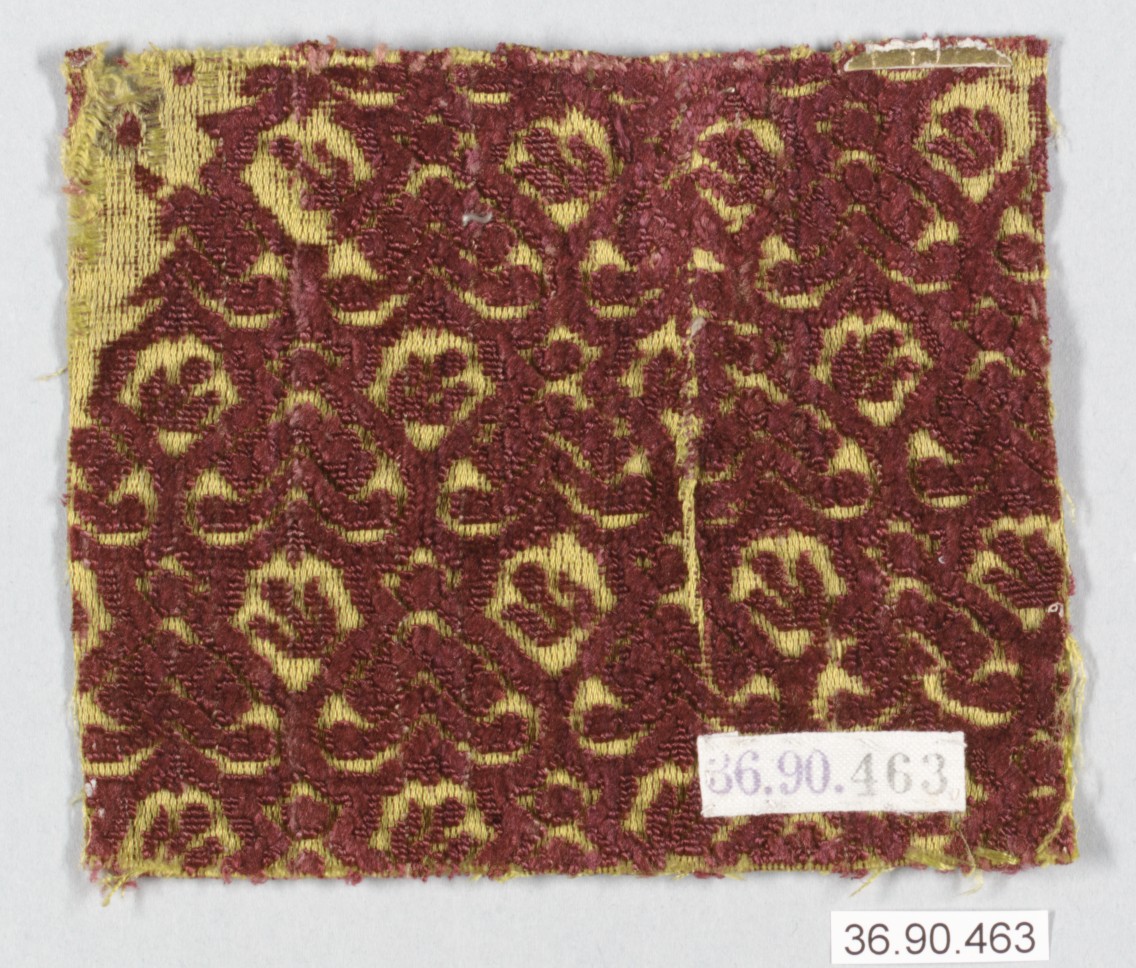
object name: piece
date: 1501-1700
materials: silk